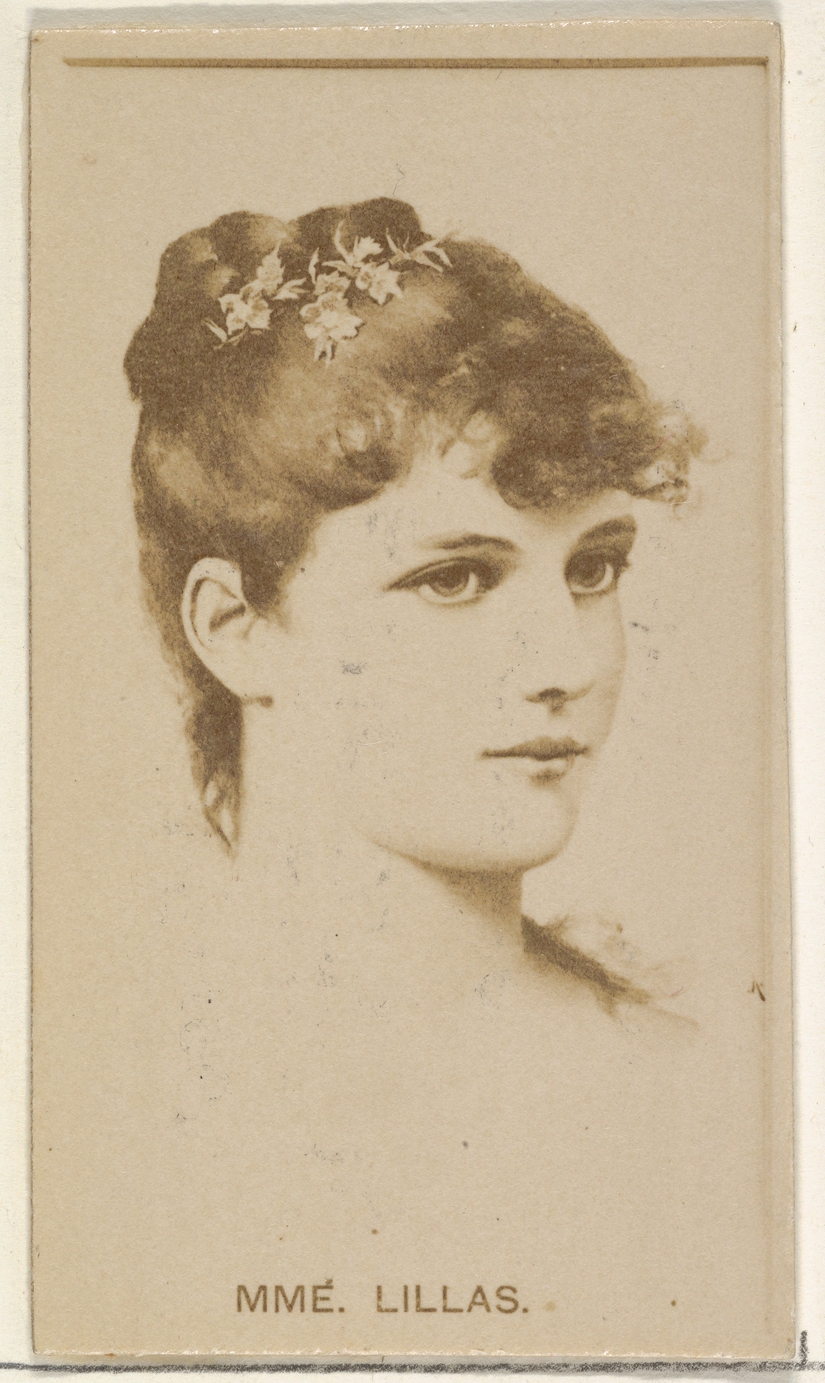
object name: photograph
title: Madame Lillas, from the Actors and Actresses series (N45, Type 8) for Virginia Brights Cigarettes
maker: allen & ginter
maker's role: publisher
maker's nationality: american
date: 1888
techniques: albumen silver print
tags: portraits,women,actresses